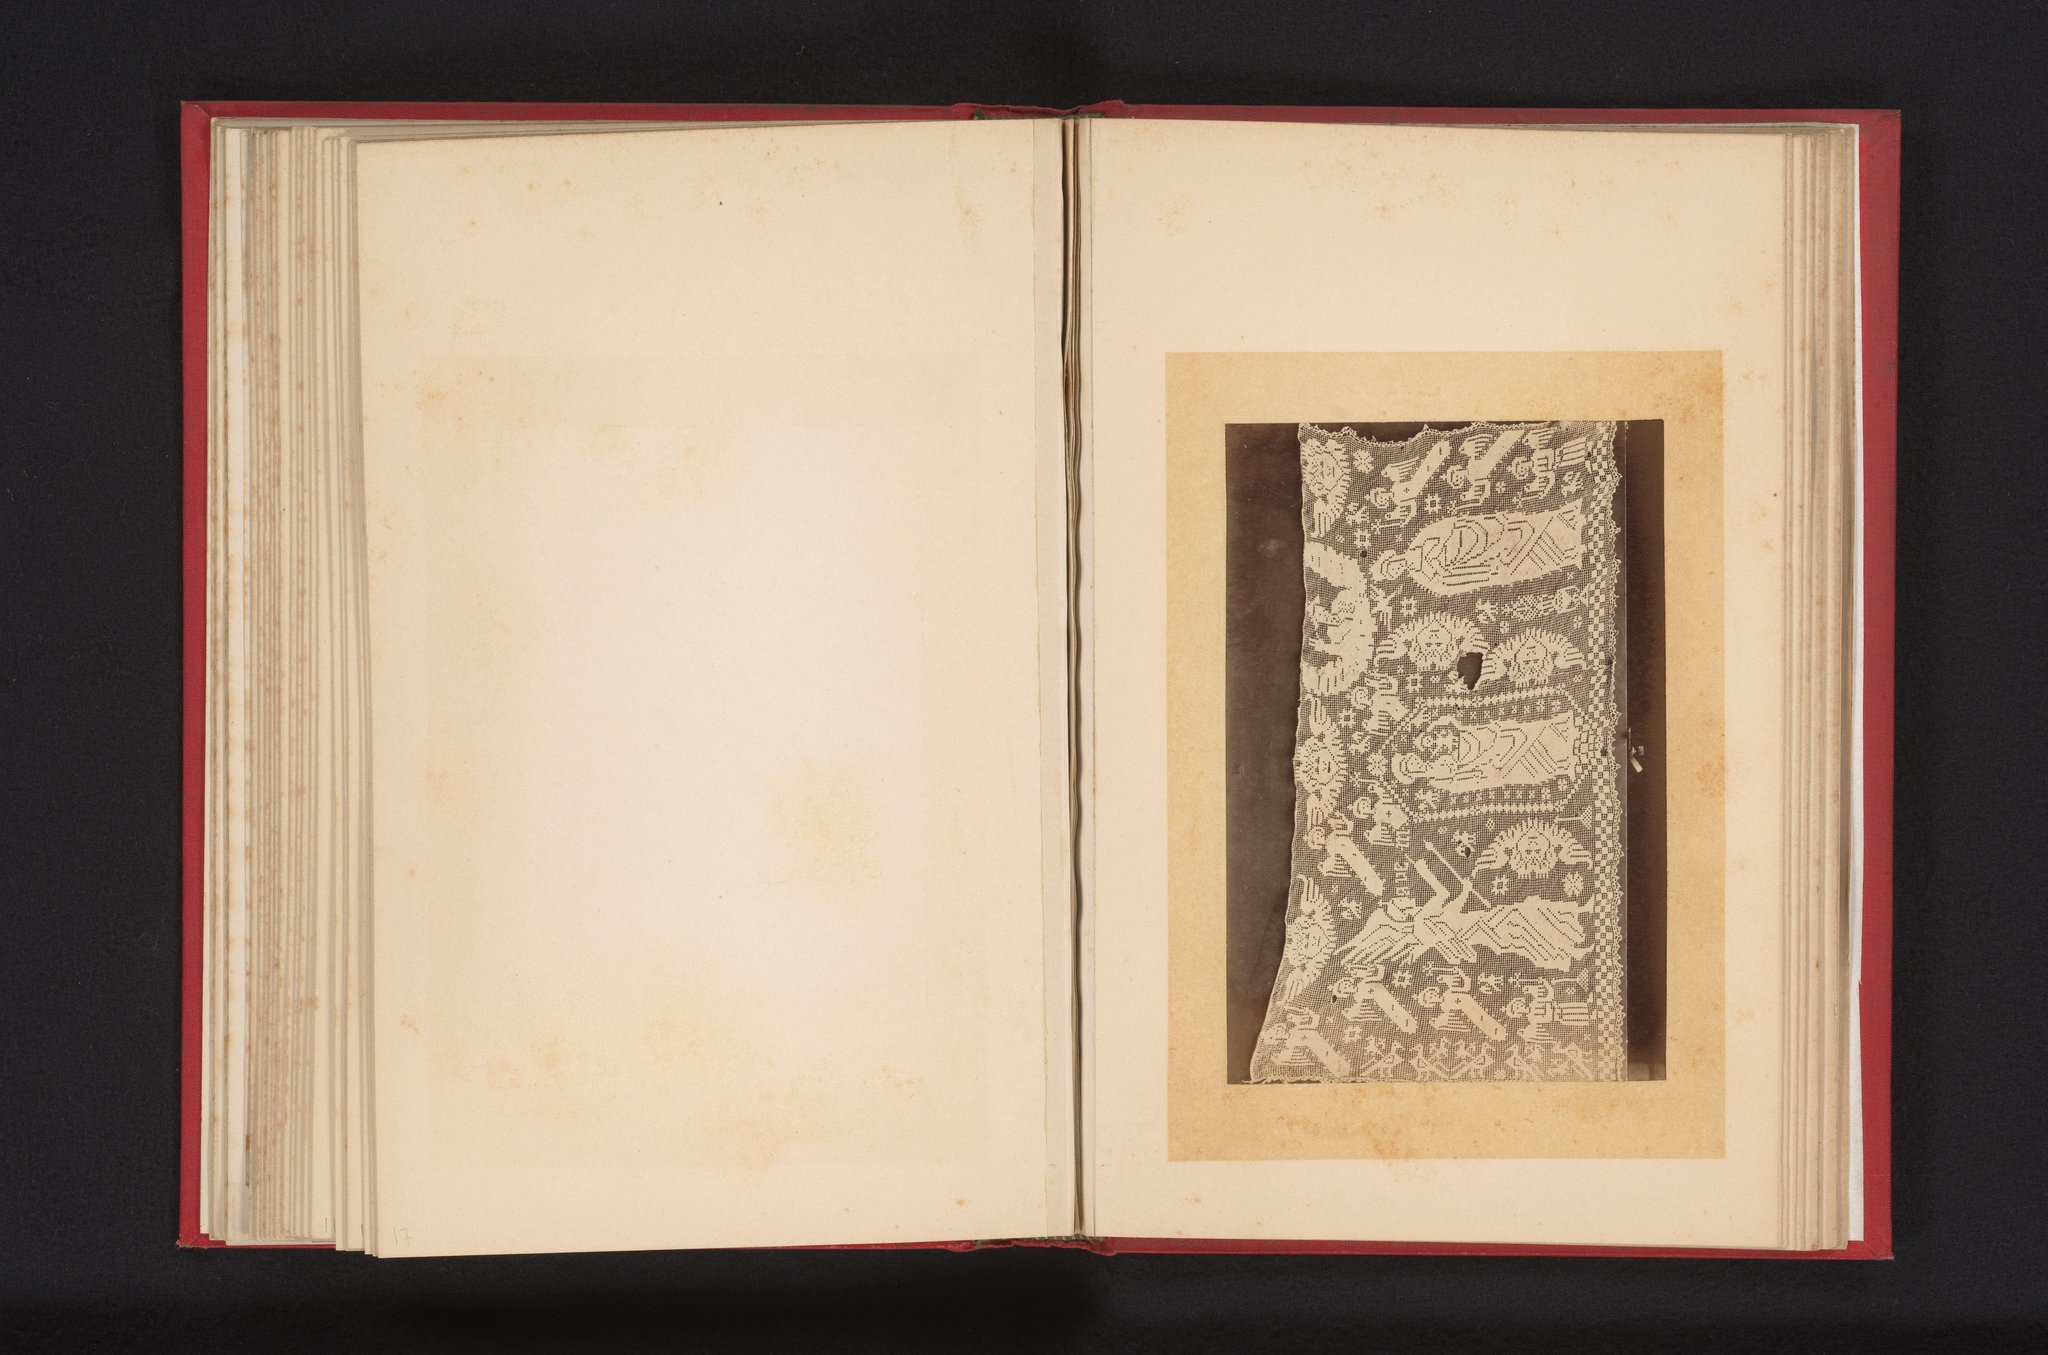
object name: page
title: Textiel met religieuze voorstelling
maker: Anonymous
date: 1873-1878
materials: photographic support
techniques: albumen print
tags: angels